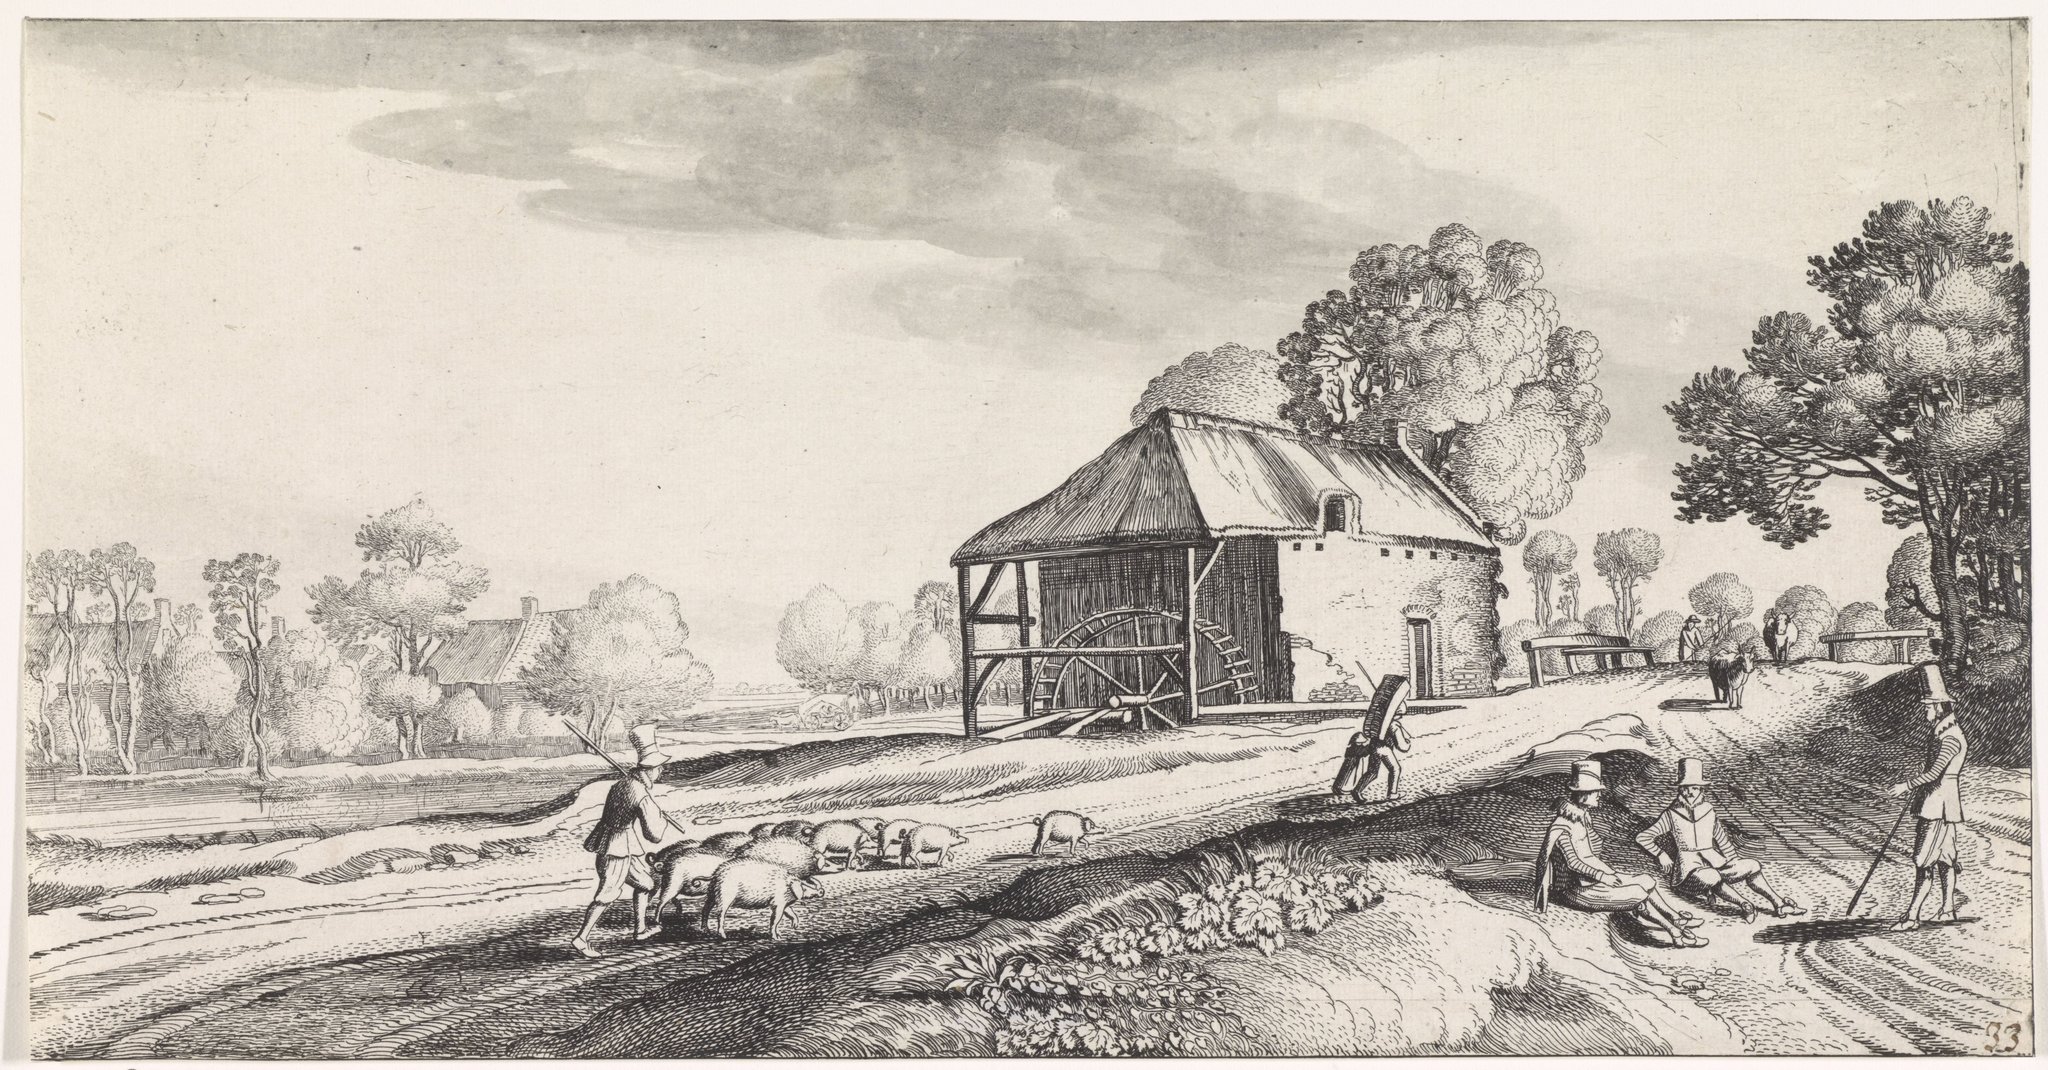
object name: print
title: Playsante lantschappen ende vermakelycke gesichten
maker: jan van de velde (ii)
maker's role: draughtsman, painter, print maker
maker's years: 1593-1641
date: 1639-1641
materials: ink, paper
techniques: brush, etching, pen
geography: northern netherlands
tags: pig, herding, herdsman, herdswoman, shepherd, shepherdess, cowherd, etc., cross-roads, bifurcation, watermill in landscape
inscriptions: number: ‘33’, collector's mark: Lugt 2228, collector's mark: Lugt 1120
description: Wegsplitsing voor een watermolen aan een rivier. Links een herder met een kudde varkens en een man met een kind; rechts een groepje pratende heren. 33ste prent van een serie met 36 prenten van landschappen, verdeeld over zes delen.